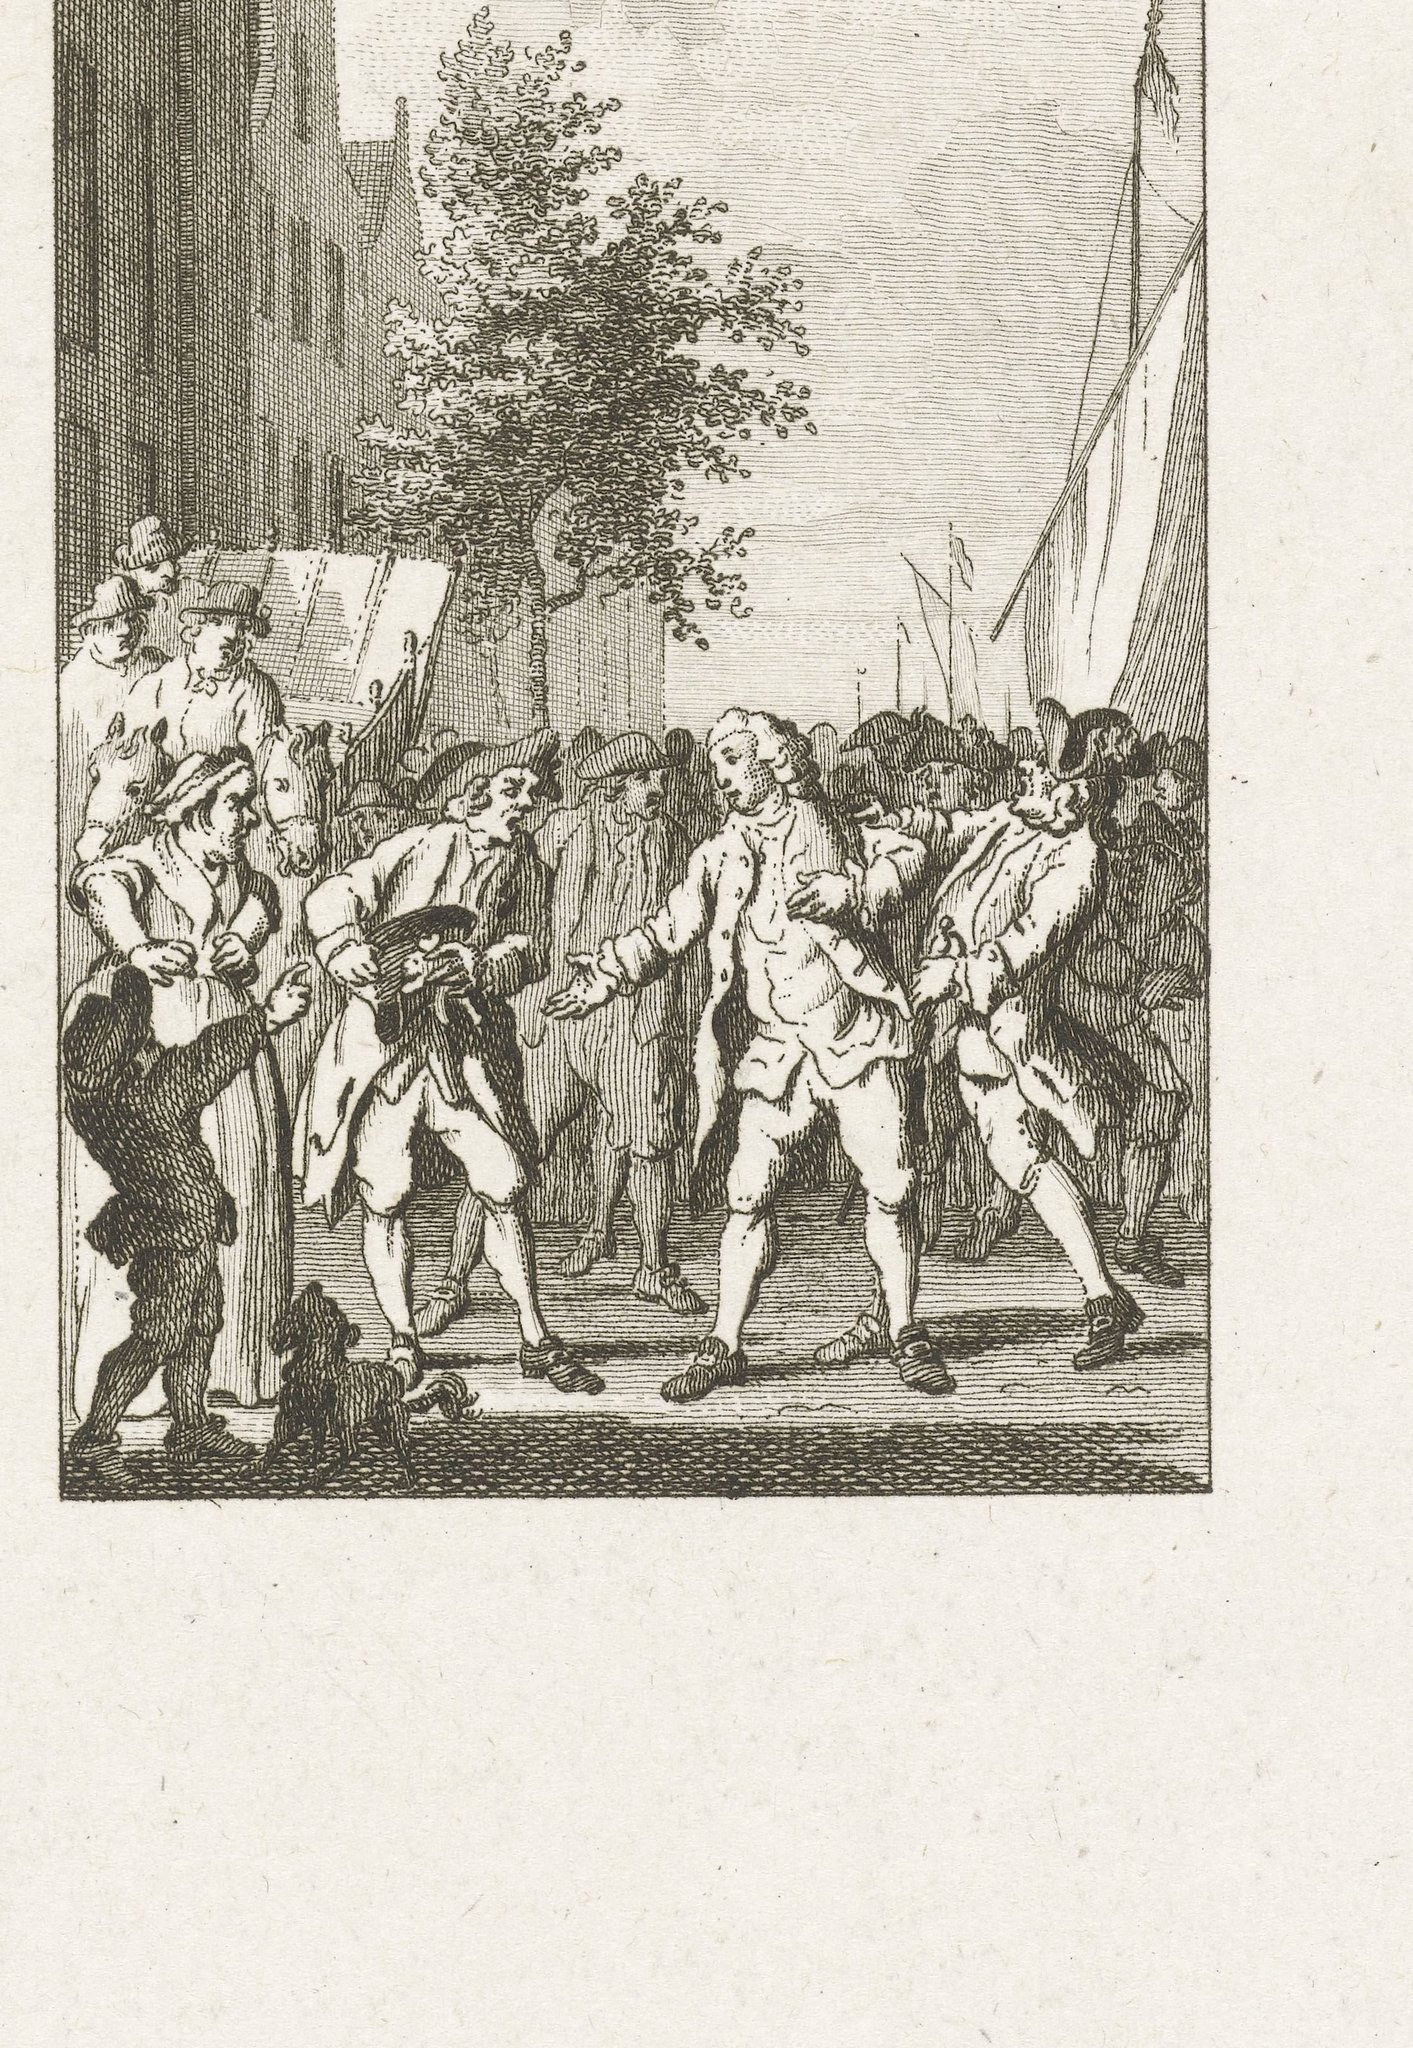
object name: history print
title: Mishandeling van Pieter Mogge van Zierikzee, 1747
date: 1780-1795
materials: paper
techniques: etching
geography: northern netherlands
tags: street-fights, riots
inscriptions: collector's mark: Lugt 2228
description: De mishandeling van Pieter Mogge, voormalig burgemeester van Zierikzee, op 29 april 1747 bij terugkeer uit Den Haag door een prinsgezinde meute op het vermoeden dat de man anti-oranjegezind was.